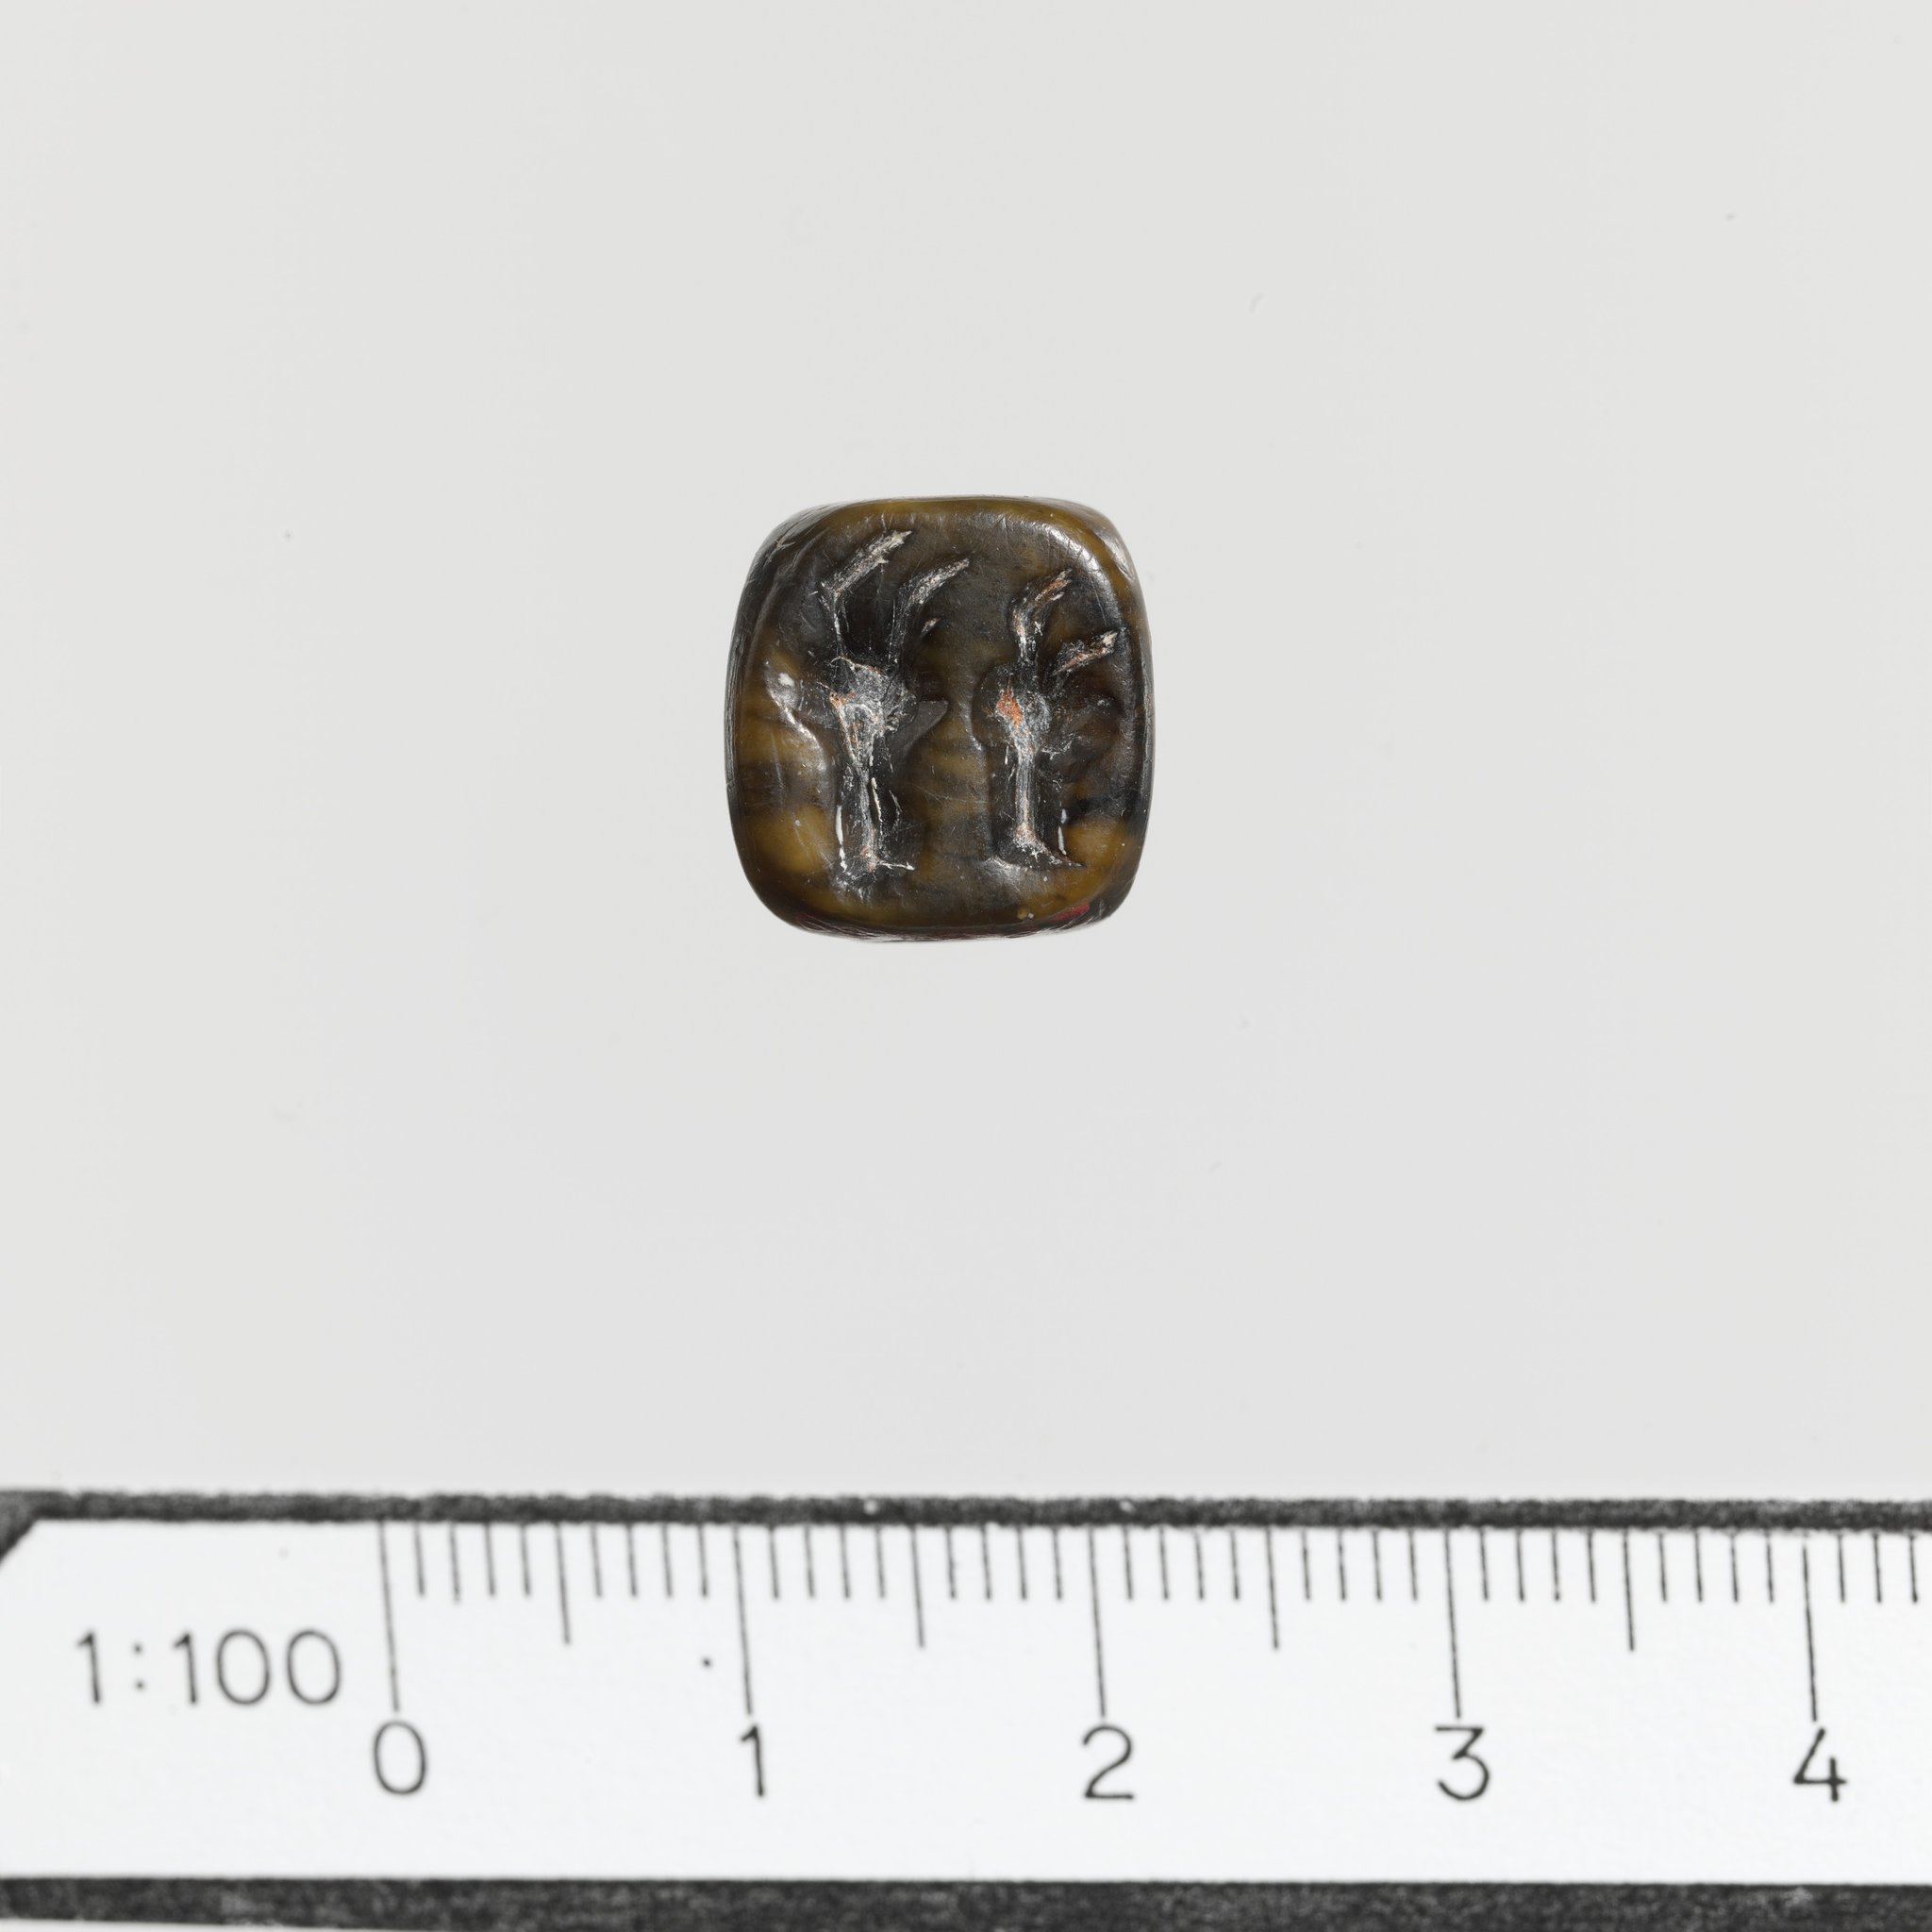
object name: seal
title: Steatite triangular prism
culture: minoan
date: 2400-2200 BCE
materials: stone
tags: bulls